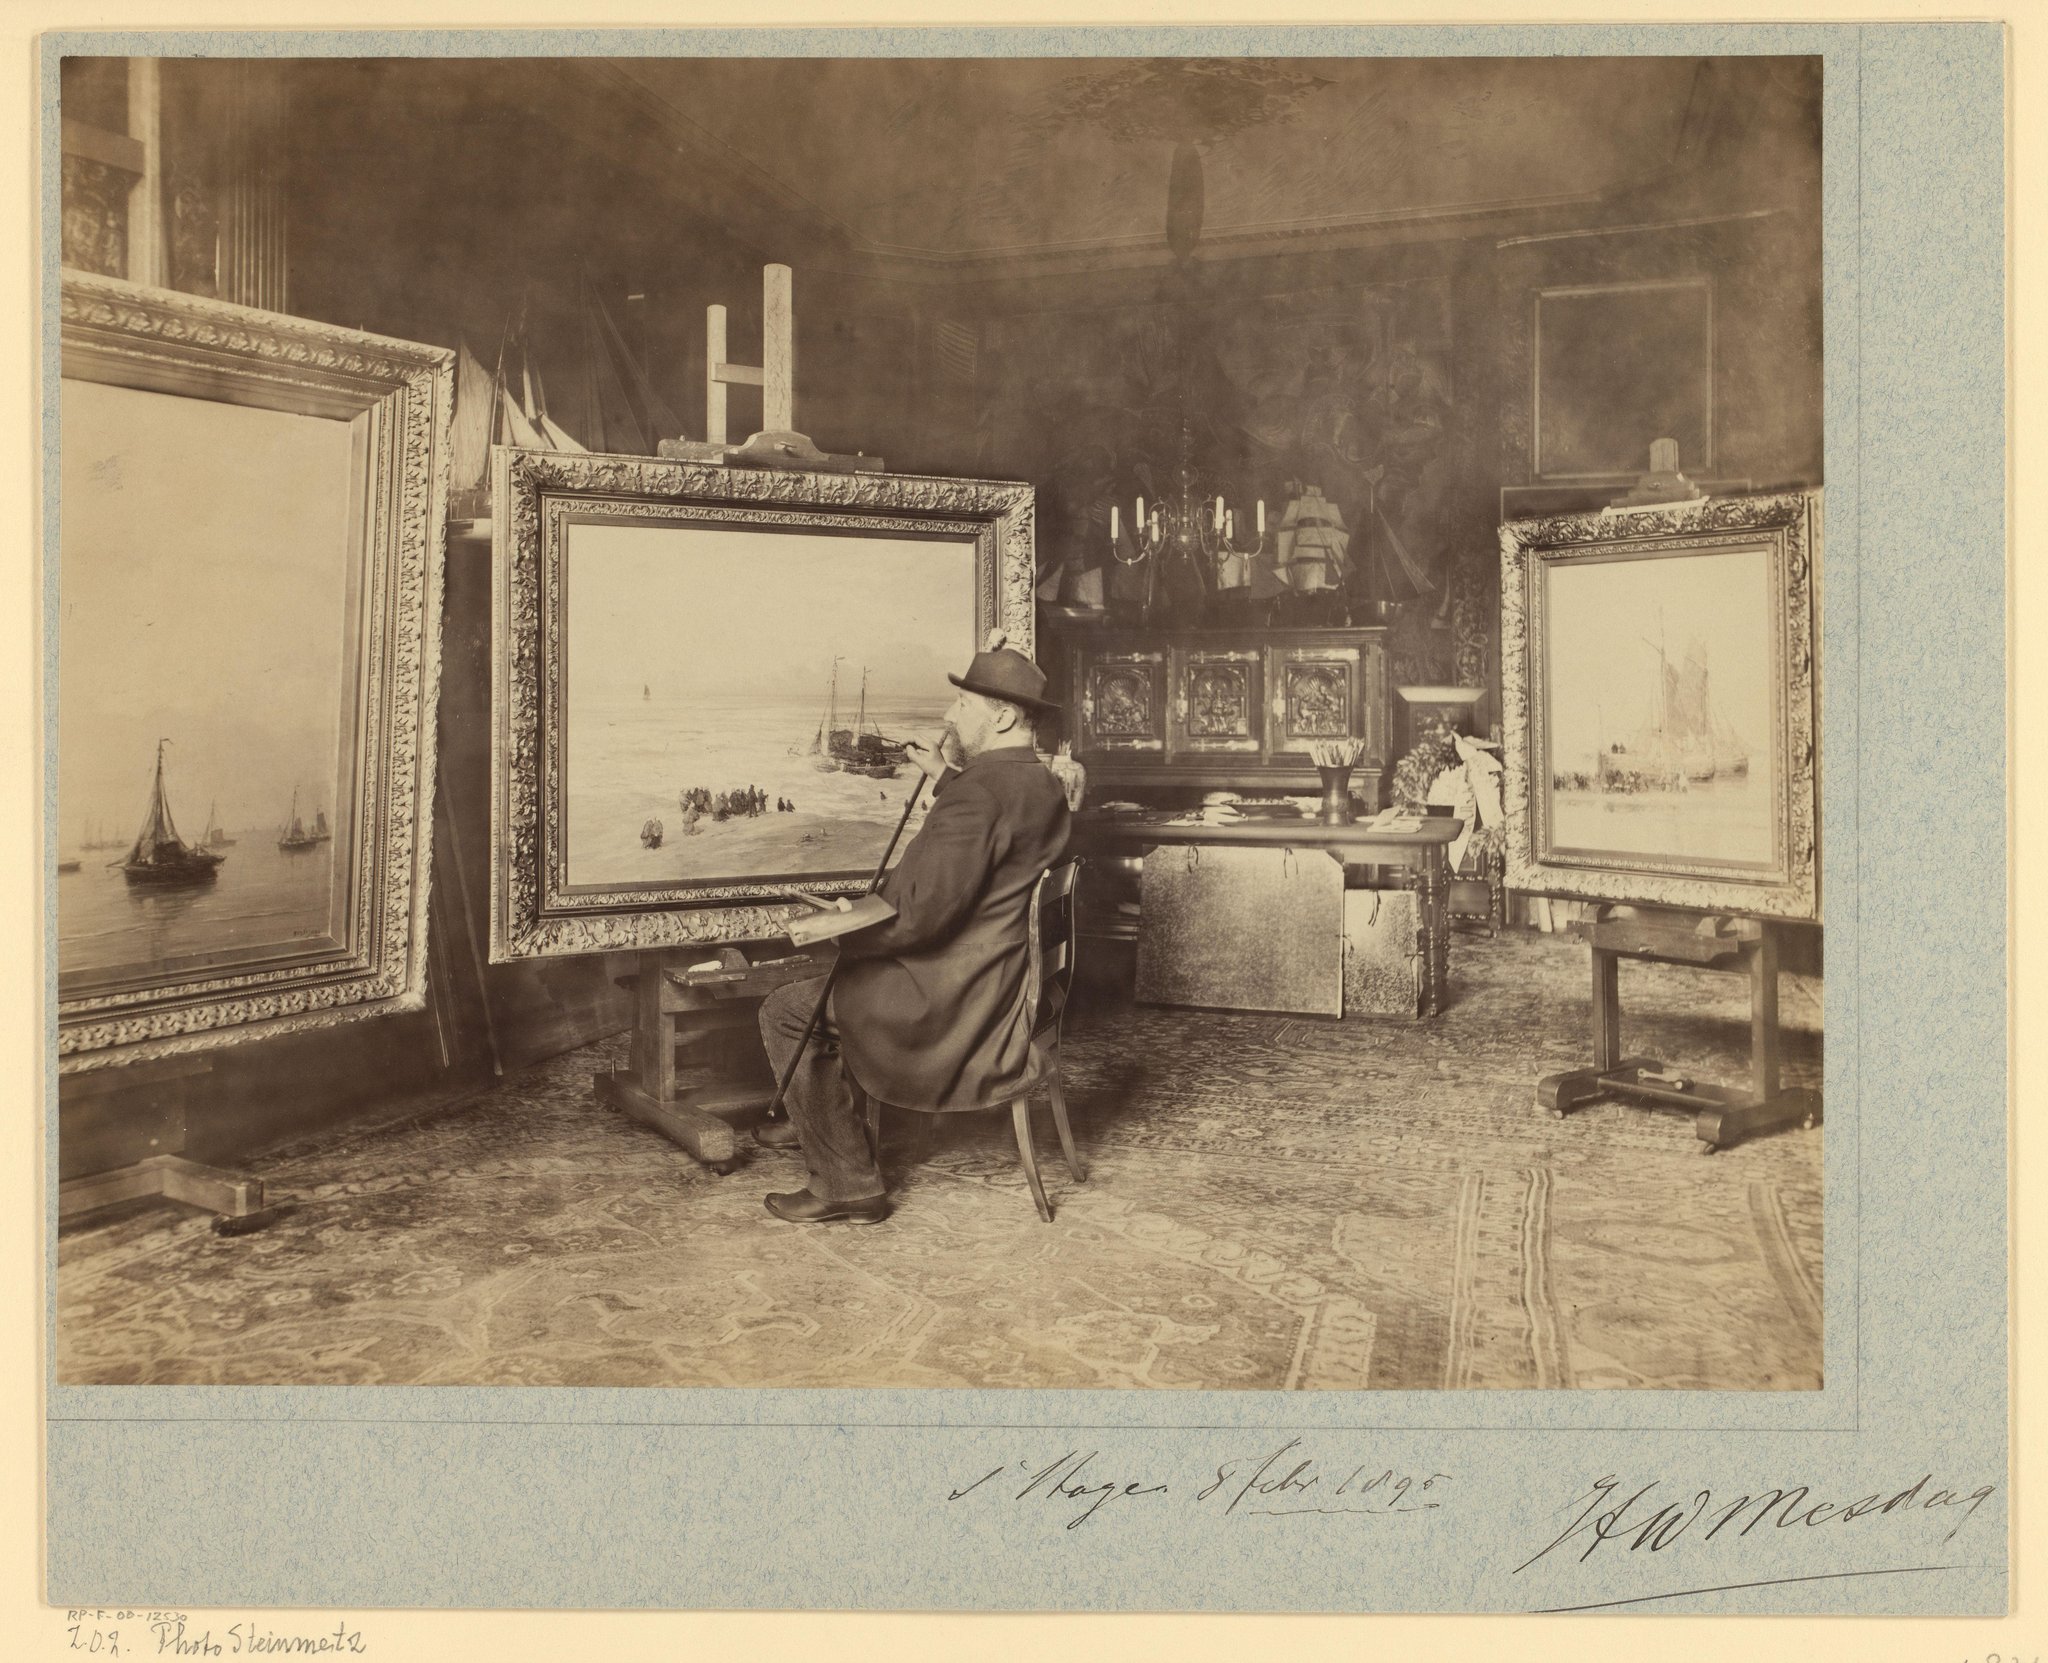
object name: photograph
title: Hendrik Willem Mesdag in zijn atelier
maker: antoine johan marinus steinmetz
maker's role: fotograaf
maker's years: 1867-1950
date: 1895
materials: cardboard, paper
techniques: albumen print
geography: the hague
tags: the hague, painter, draughtsman, hendrik willem mesdag, historical persons